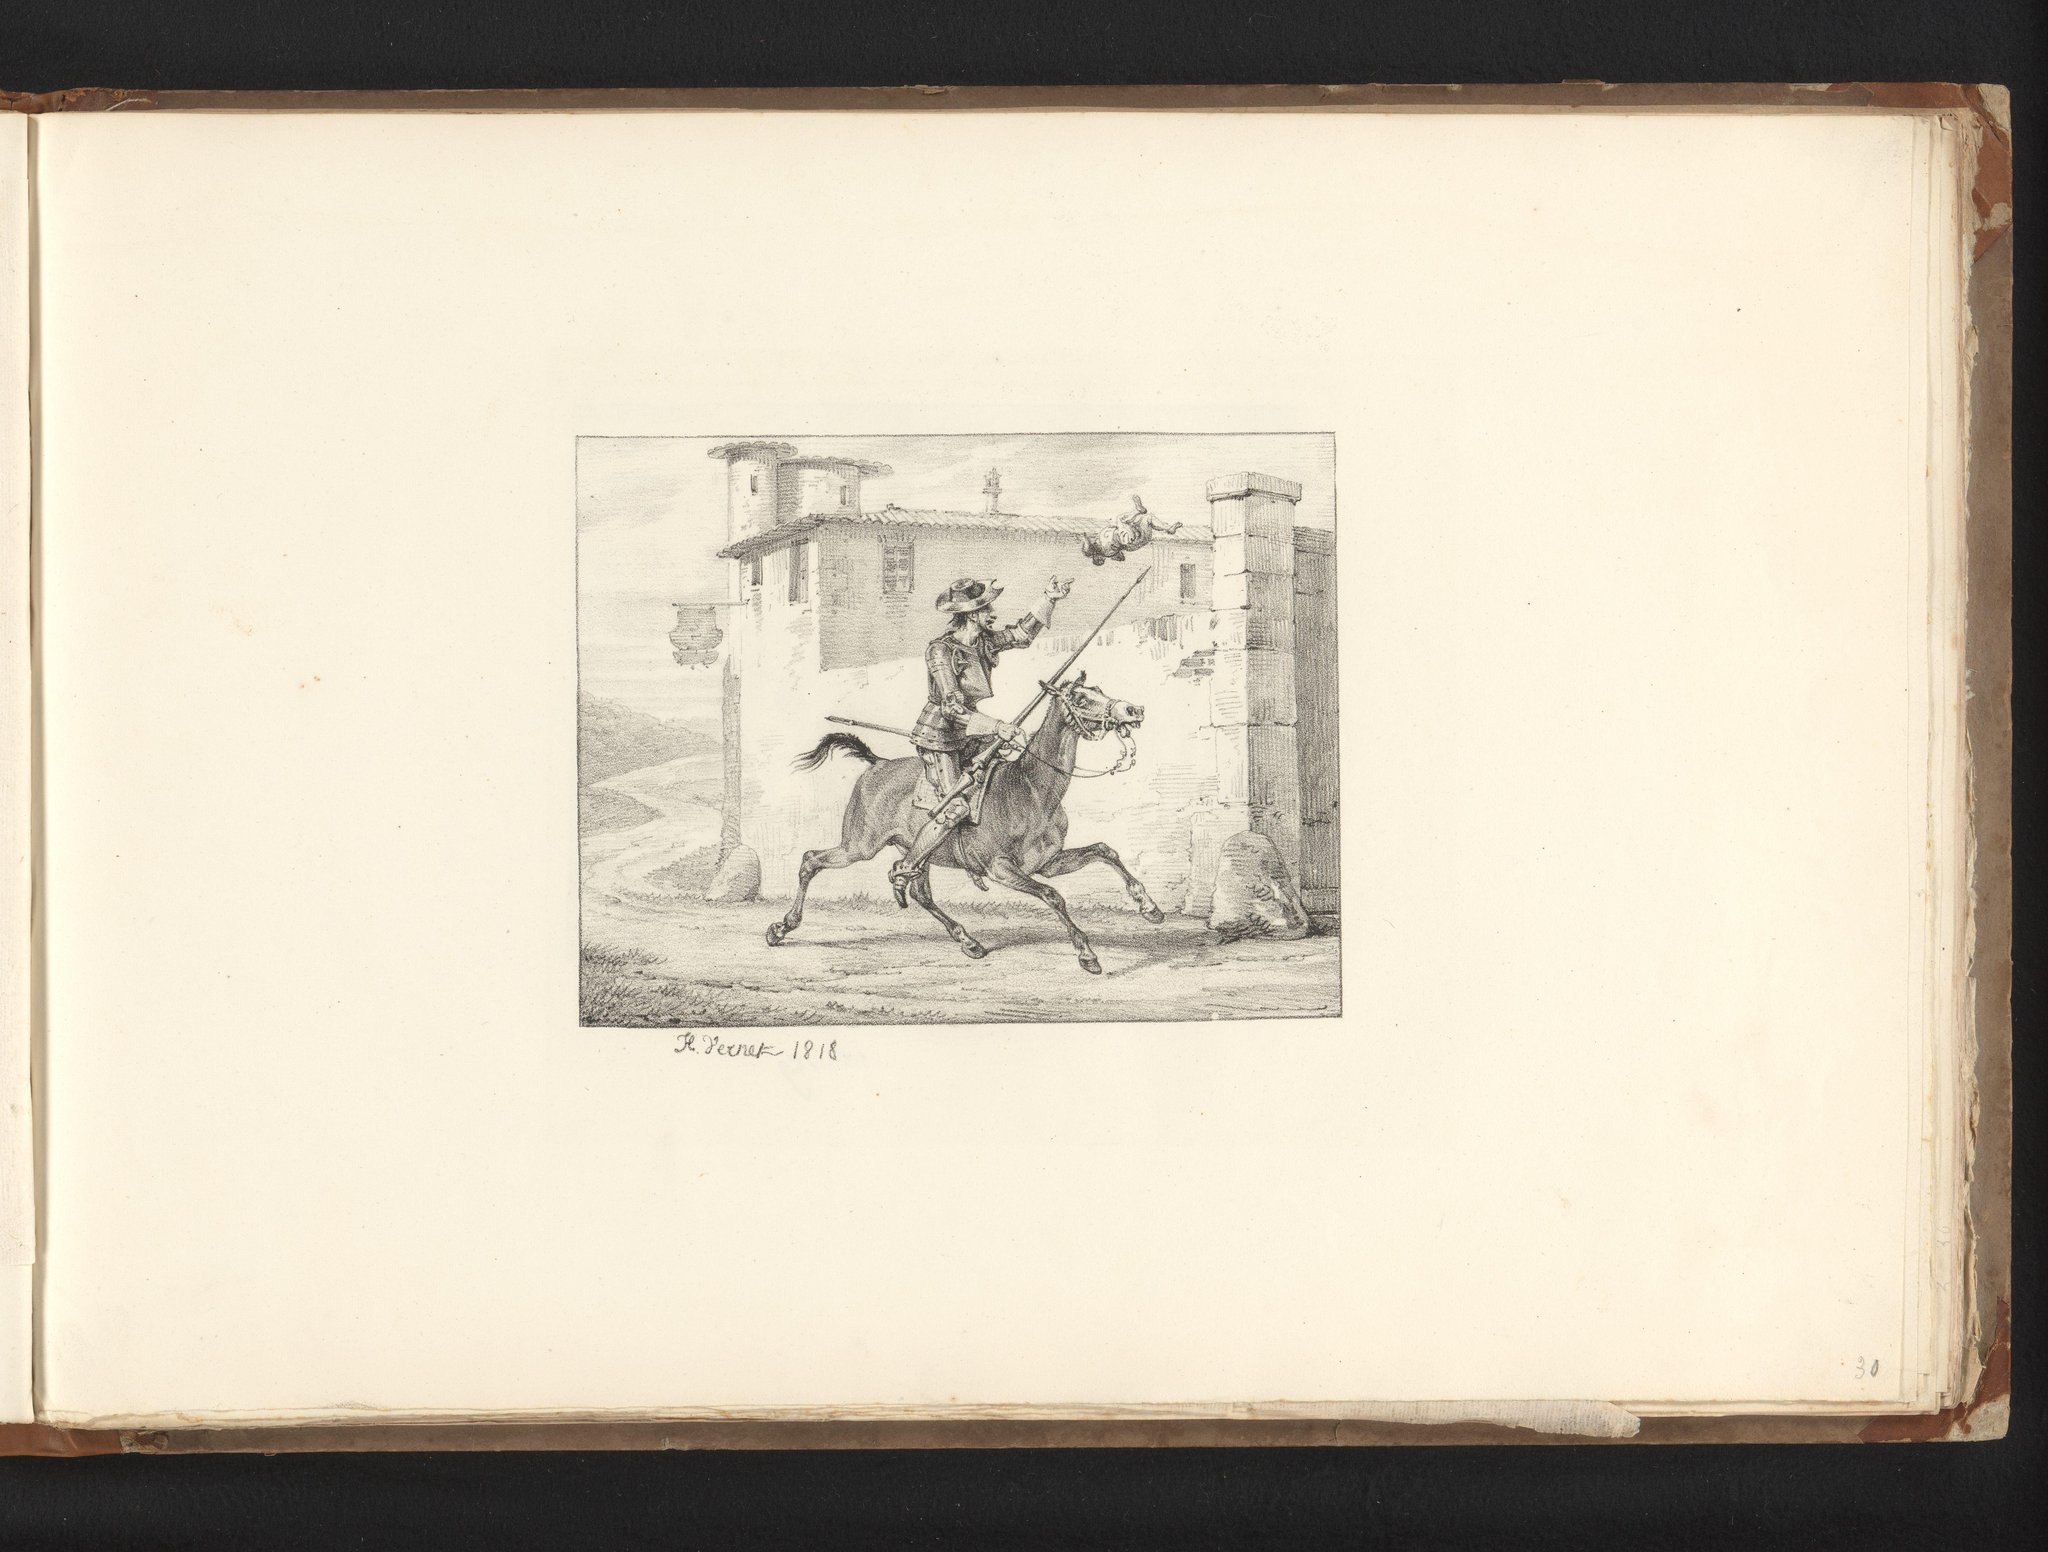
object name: album leaf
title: Don Quichot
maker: horace vernet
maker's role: draughtsman, painter, print maker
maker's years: 1789-1863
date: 1818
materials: paper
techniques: lithograph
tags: don quixote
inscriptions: date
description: Ridder te paard, waarschijnlijk Don Quichot. Prent maakt deel uit van een album.